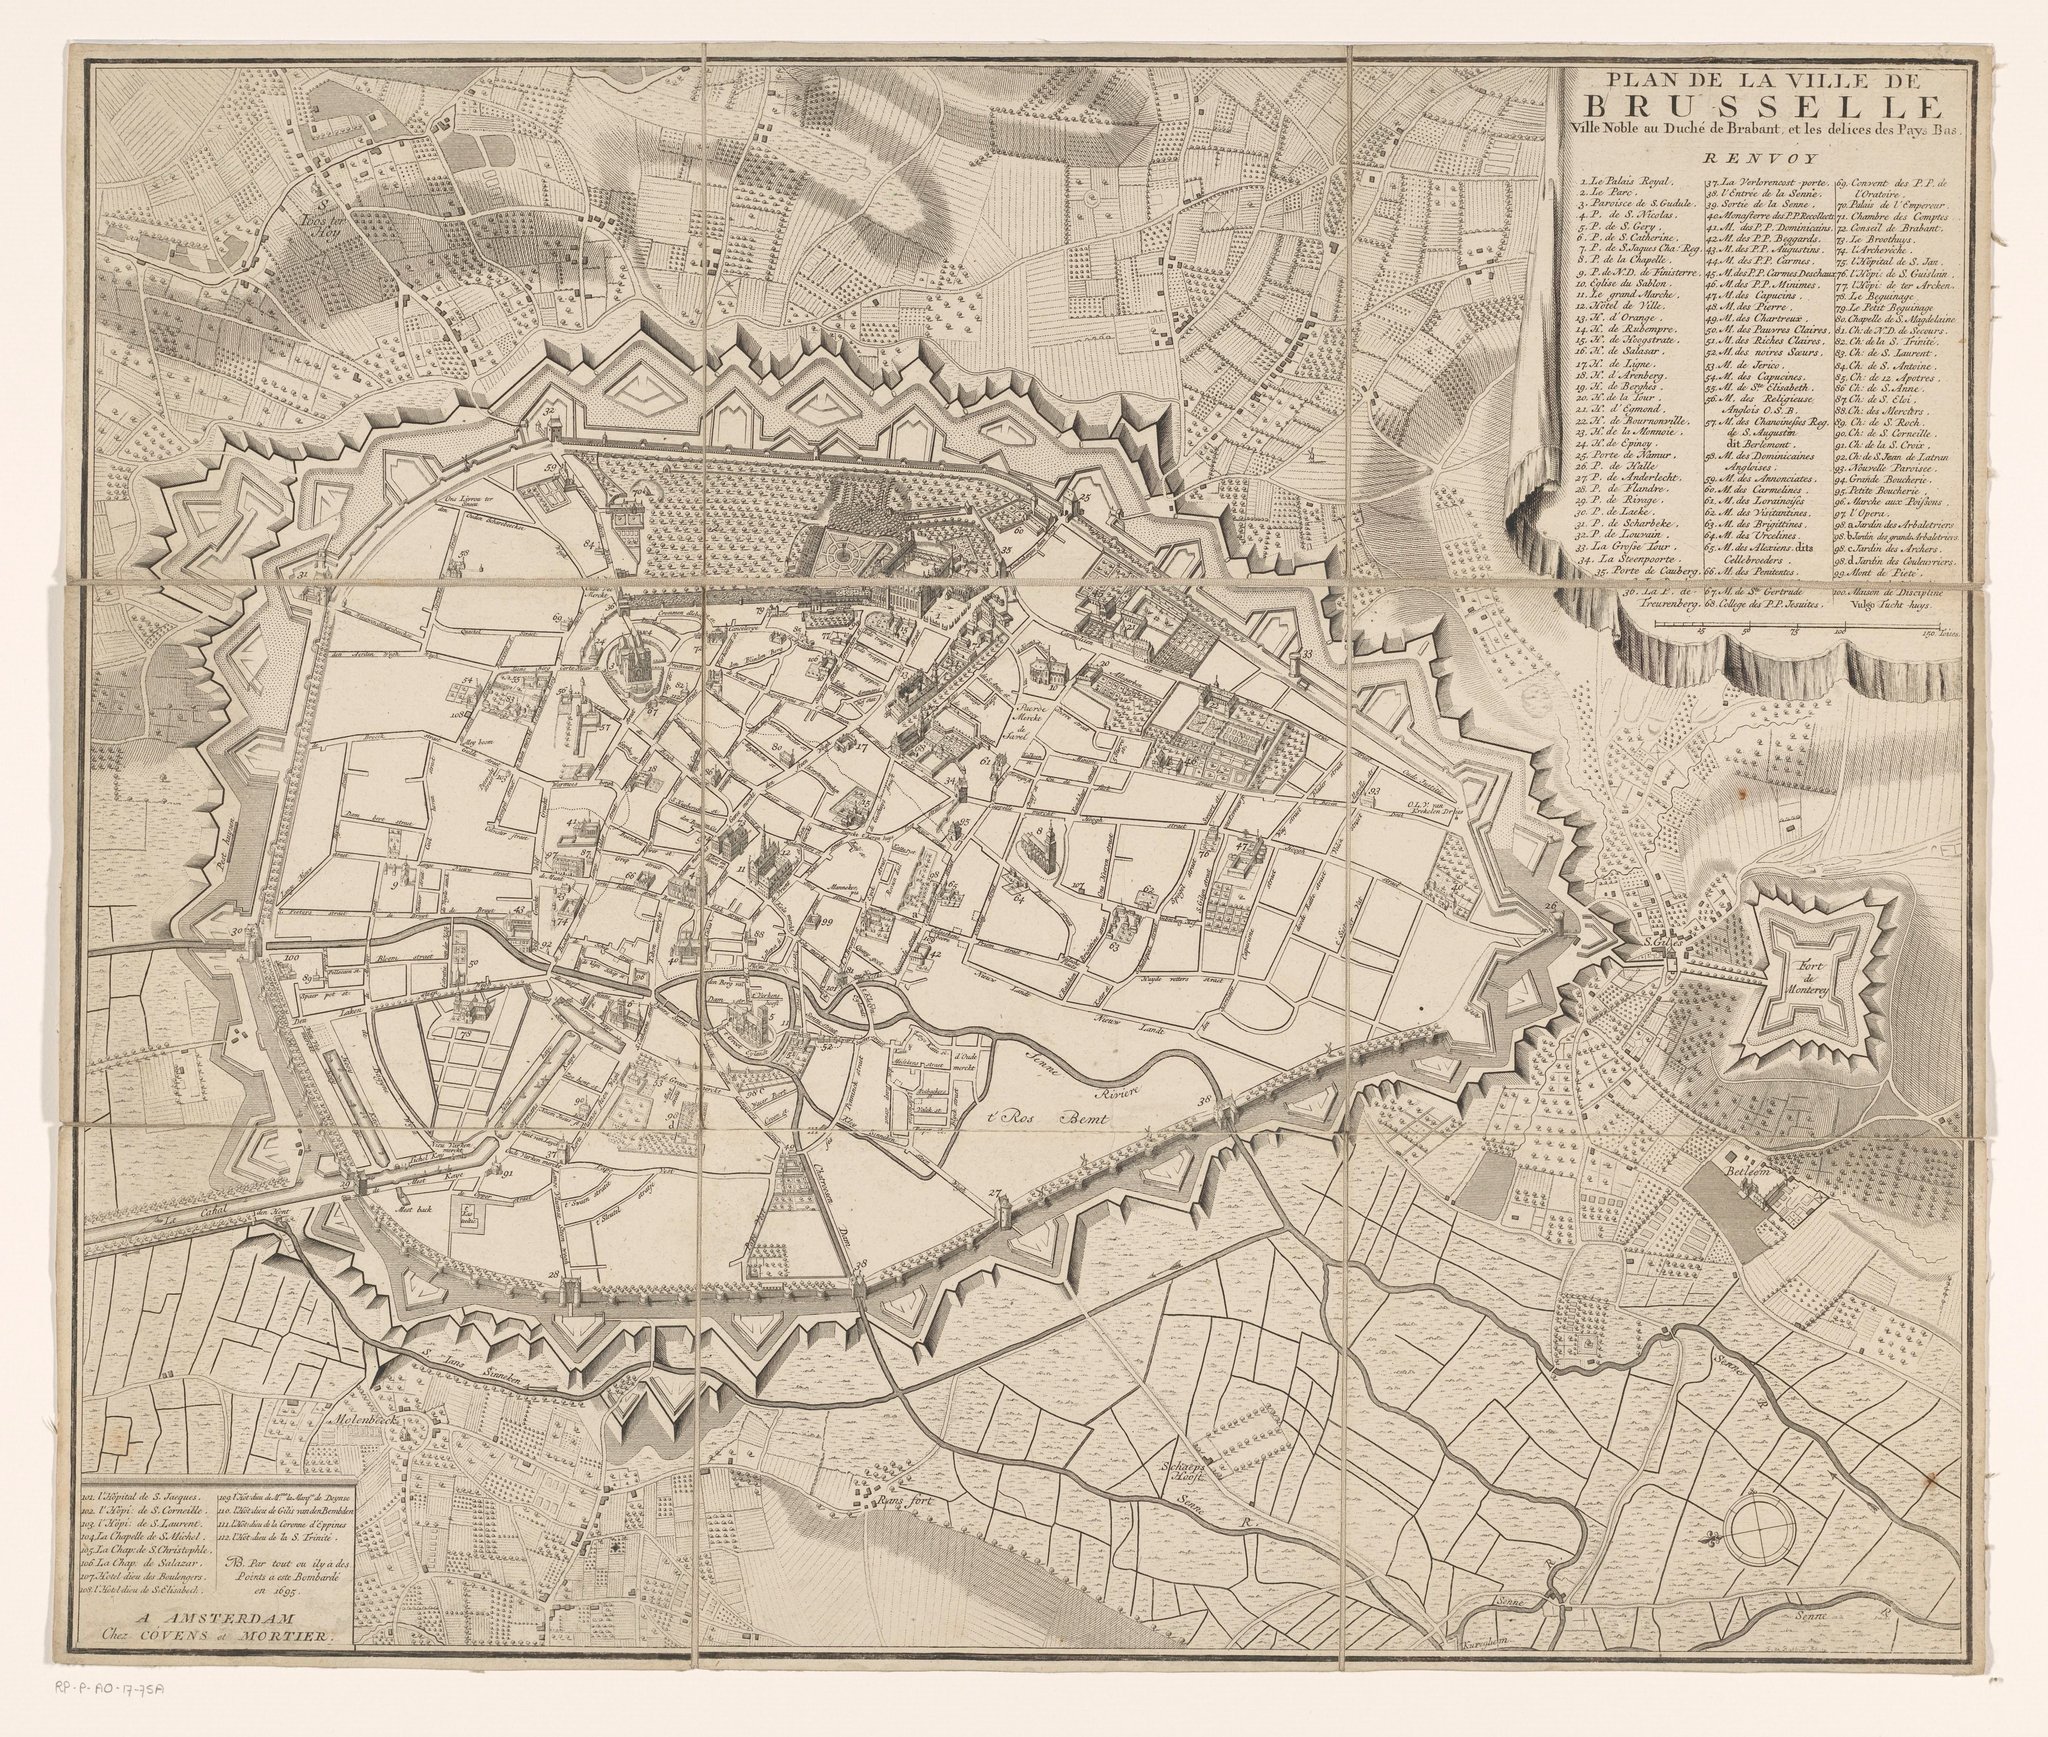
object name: print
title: Plan de la ville de Brusselles (...)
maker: frans de bakker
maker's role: print maker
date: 1736-1774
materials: paper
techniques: engraving, etching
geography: amsterdam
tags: fortified city, maps of cities, brussels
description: Plattegrond van Brussel met gebouwen in vogelvluchtperspectief. Rechtsboven een cartouche met titel, legenda 1-100 en schaalstok: 150 Toises. Linksonder een kader met het vervolg van de legenda, 101-112.